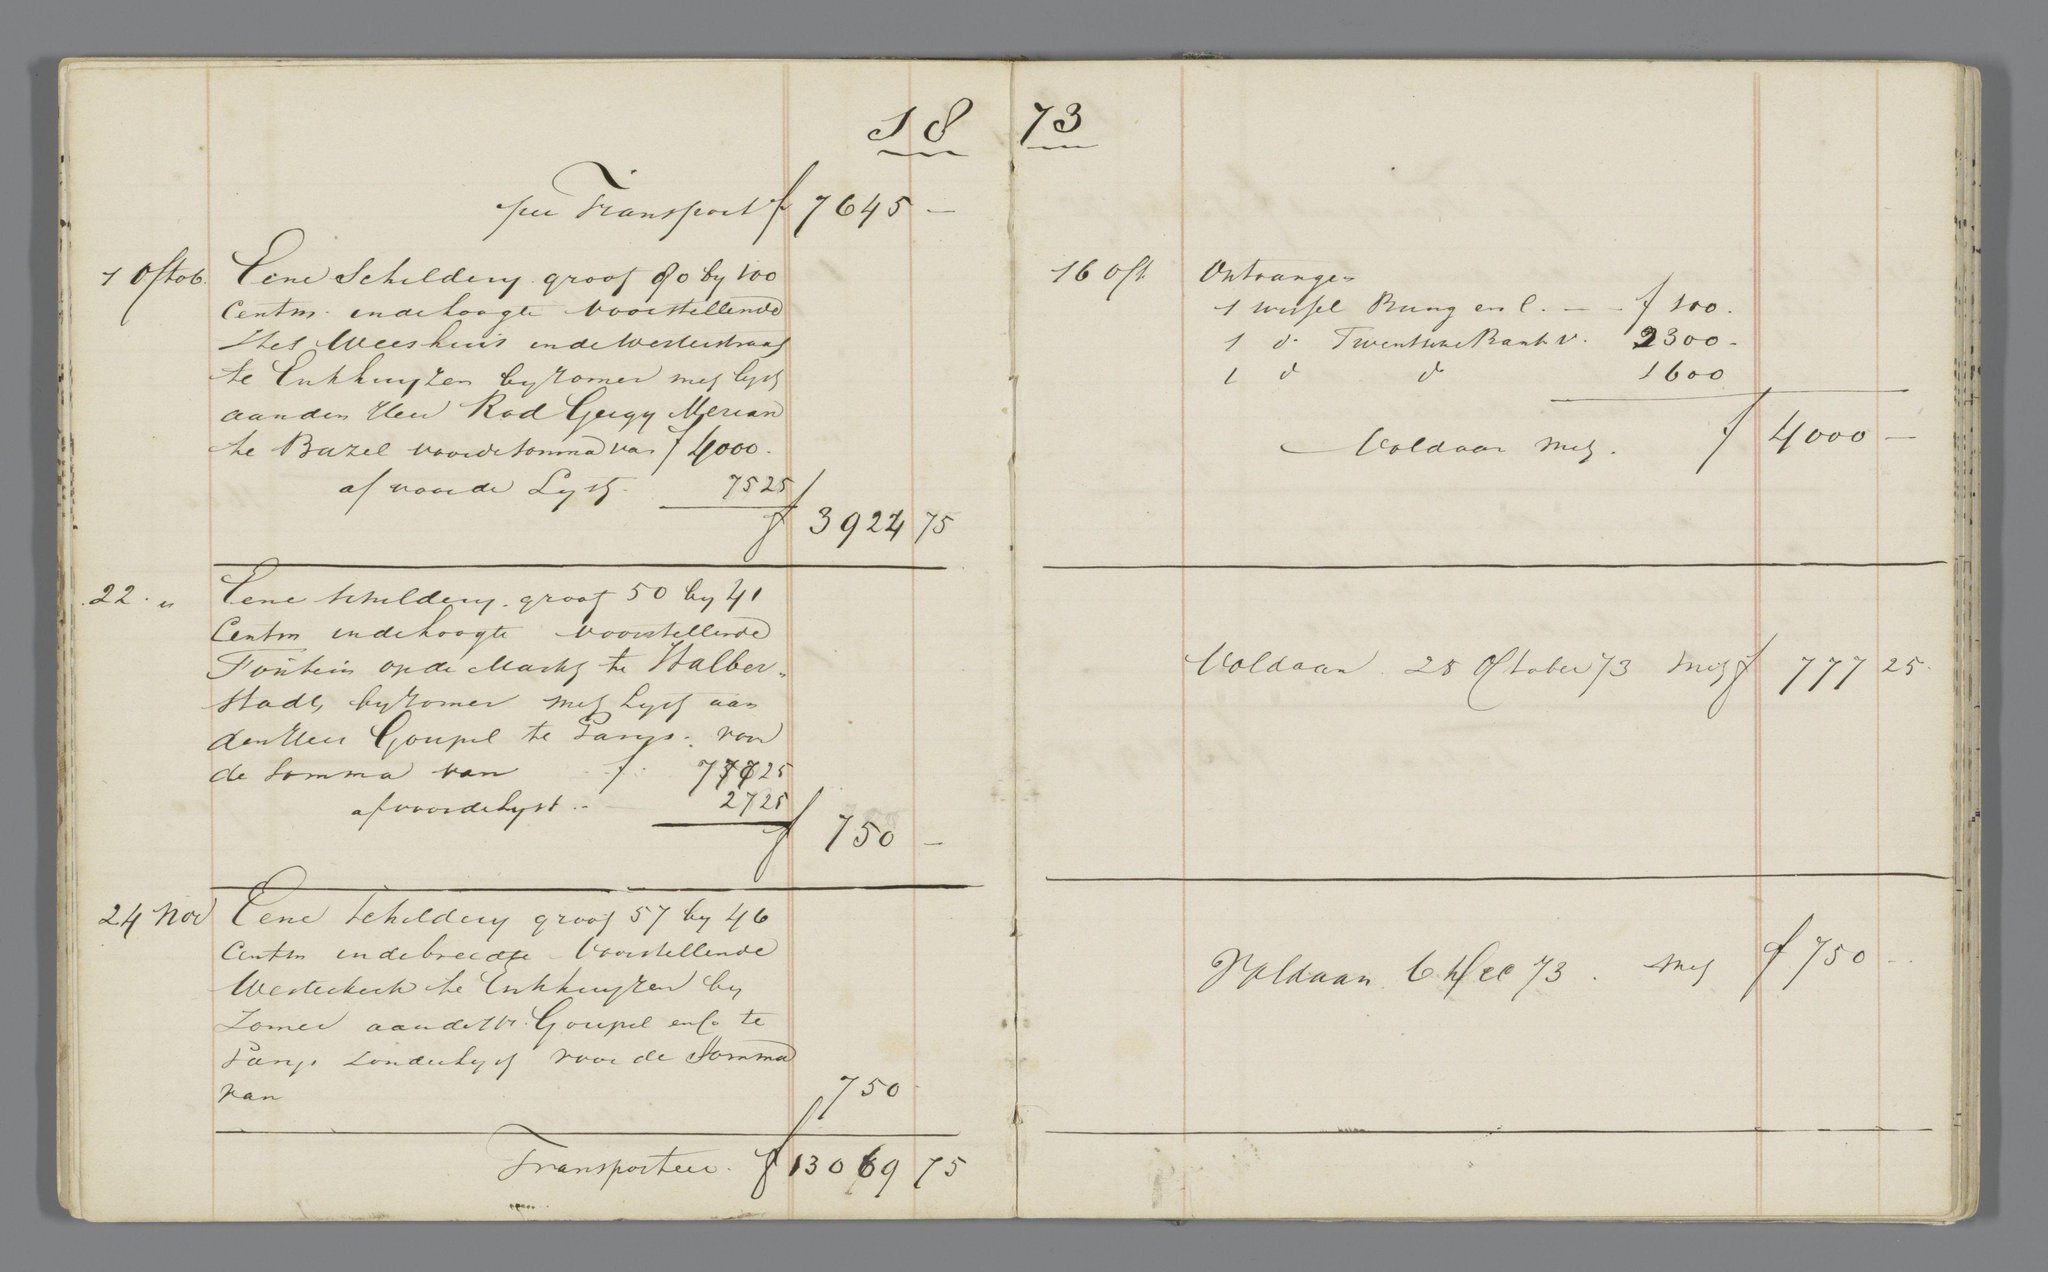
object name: notebook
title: Verkoopboek 1868-1887 Schilderijen enz.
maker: cornelis springer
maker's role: draughtsman, painter, print maker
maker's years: 1817-1891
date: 1868-1887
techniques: writing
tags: amsterdam, painter, print maker, draughtsman, cornelis springer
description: Verkoopboek met groen en bruin gemarmerd omslag en linnen rug.